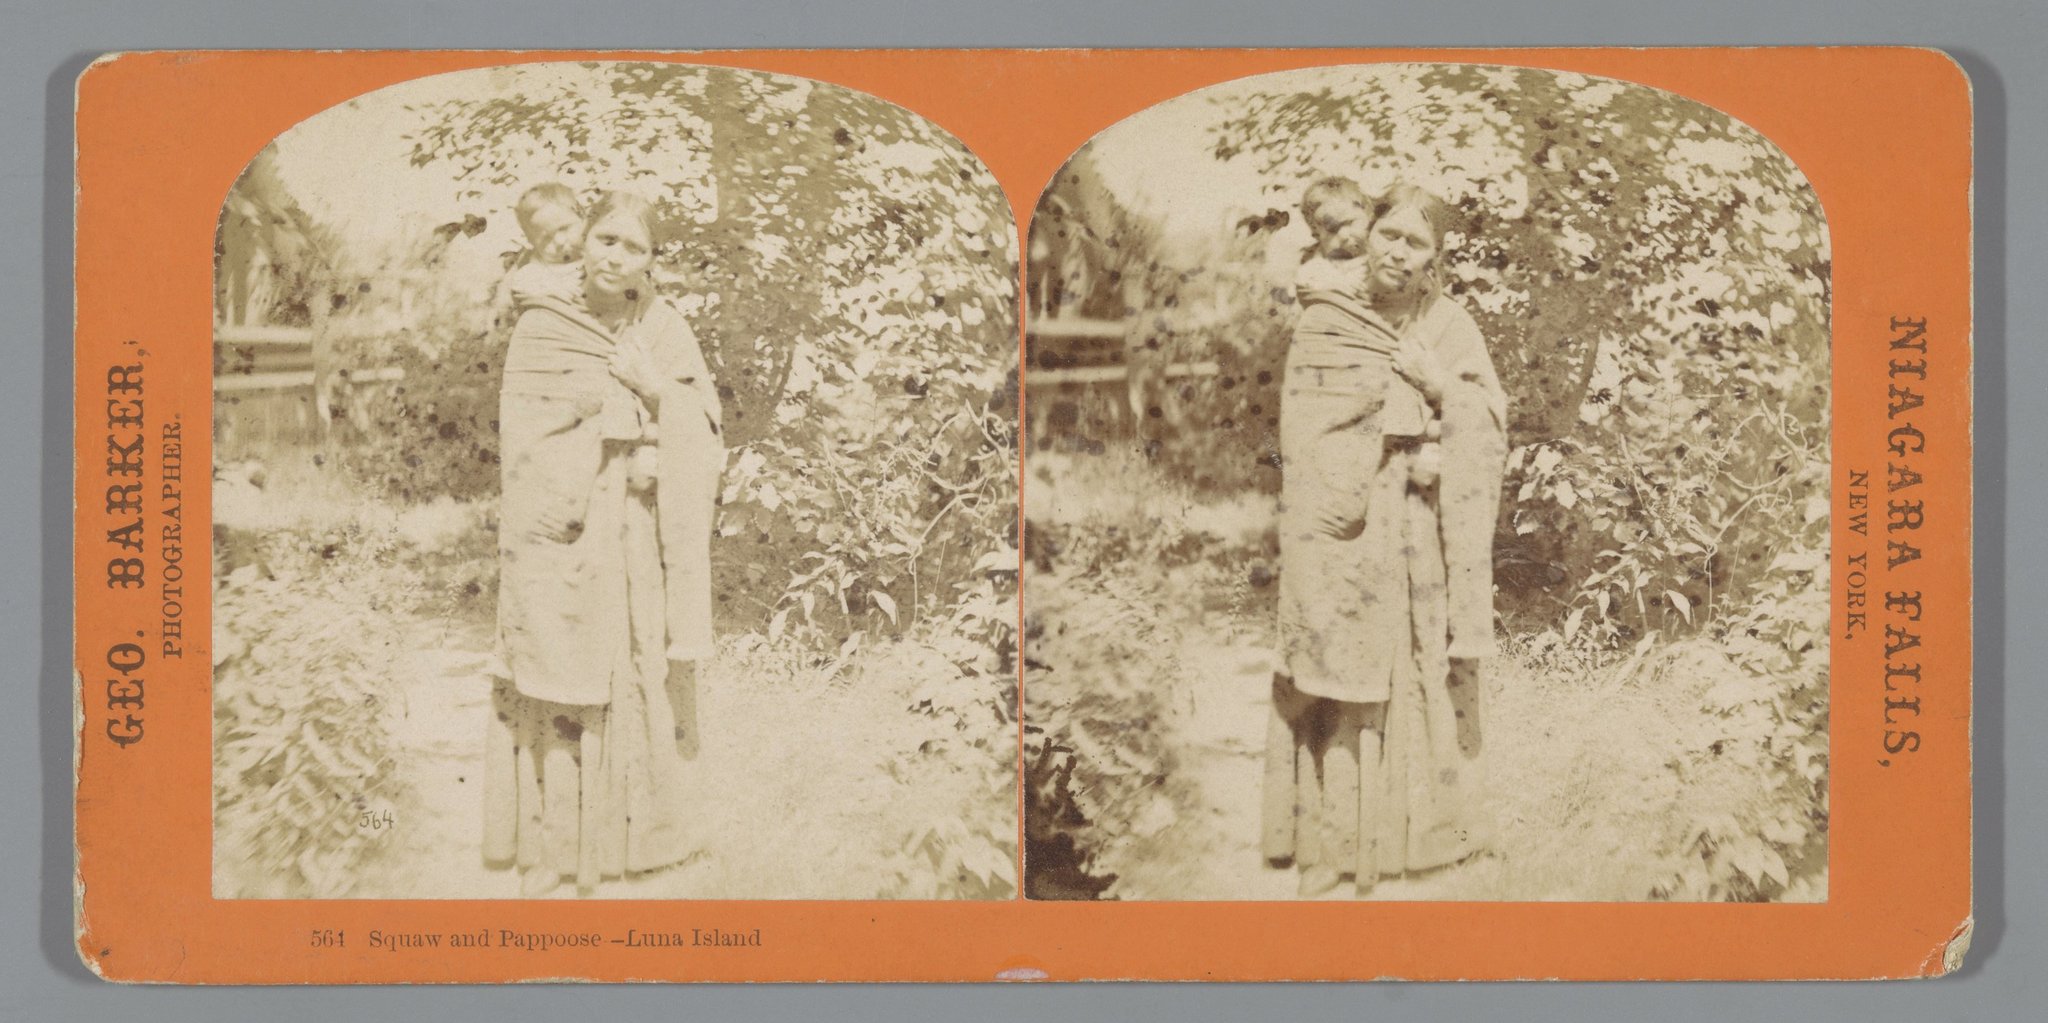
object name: stereograph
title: Niagara Falls, New York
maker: george barker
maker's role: fotograaf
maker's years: 1844-1894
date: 1863-1894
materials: cardboard, paper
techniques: albumen print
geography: luna island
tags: indigenous peoples of north america, mother and baby or young child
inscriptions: number: ‘564’, number: ‘564’